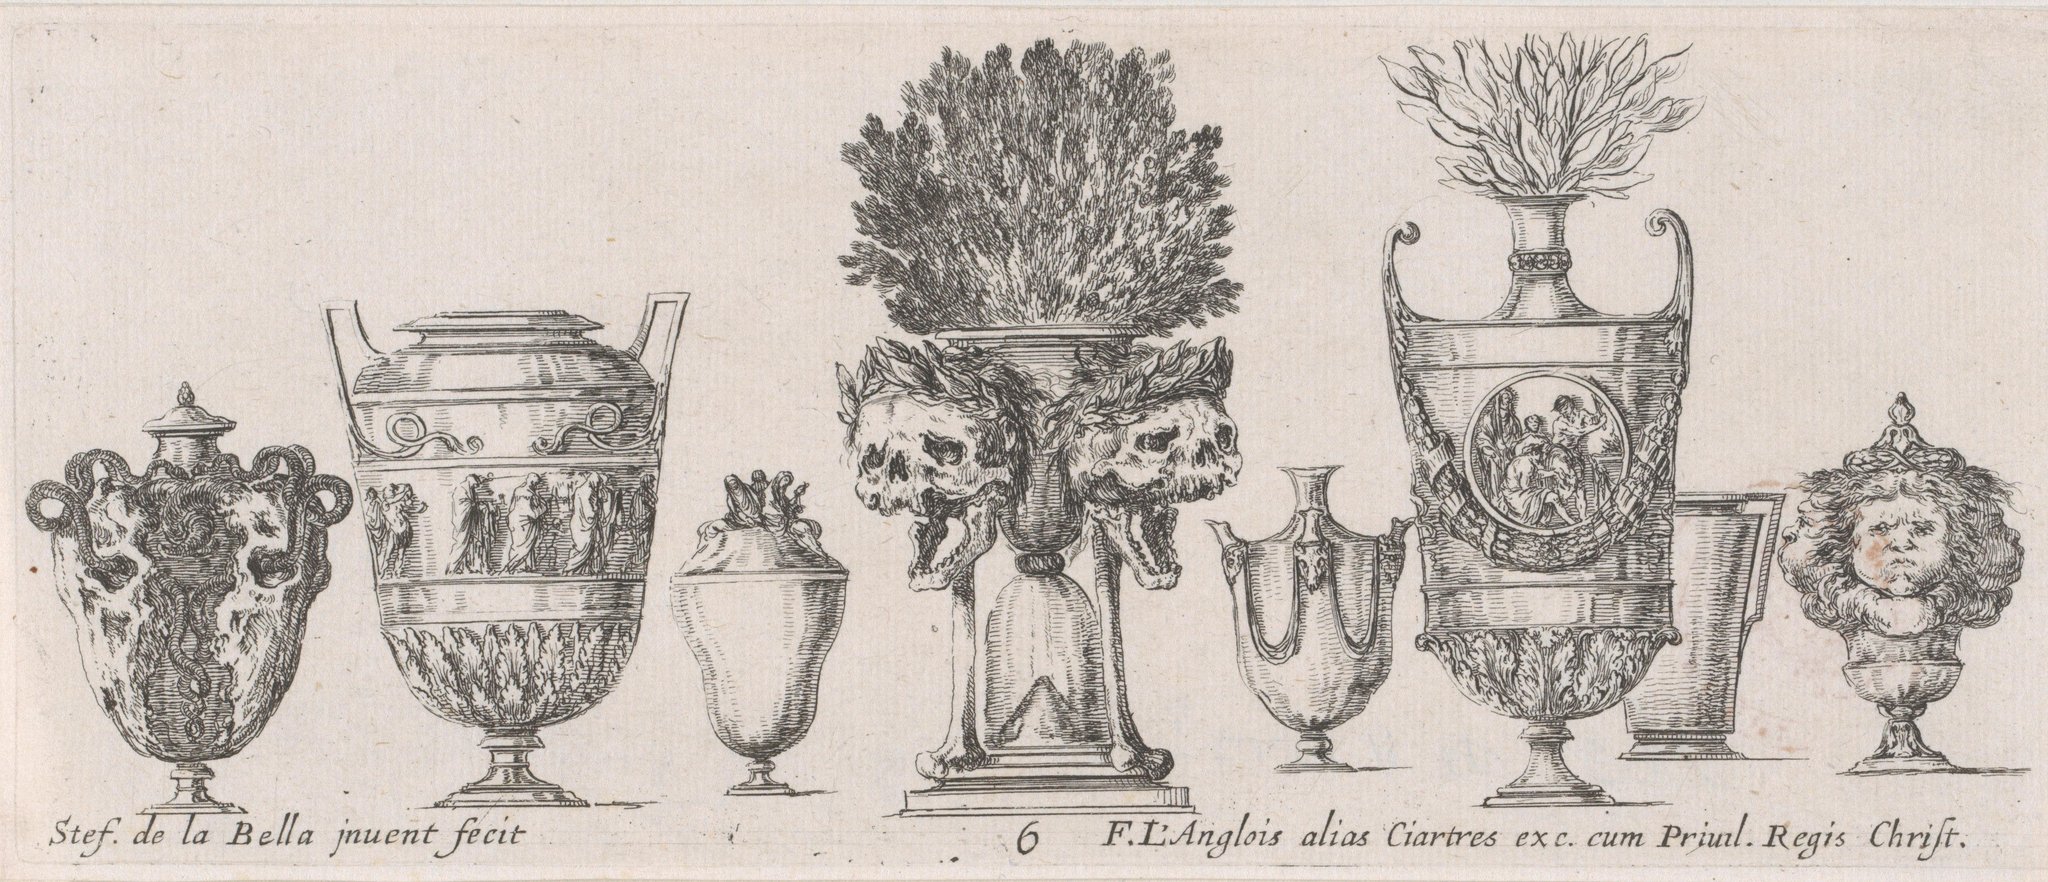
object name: print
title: Raccolta di vasi diversi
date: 1620-1664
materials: paper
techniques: etching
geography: paris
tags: vase ~ ornament, garden vase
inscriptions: collector's mark: Lugt 240